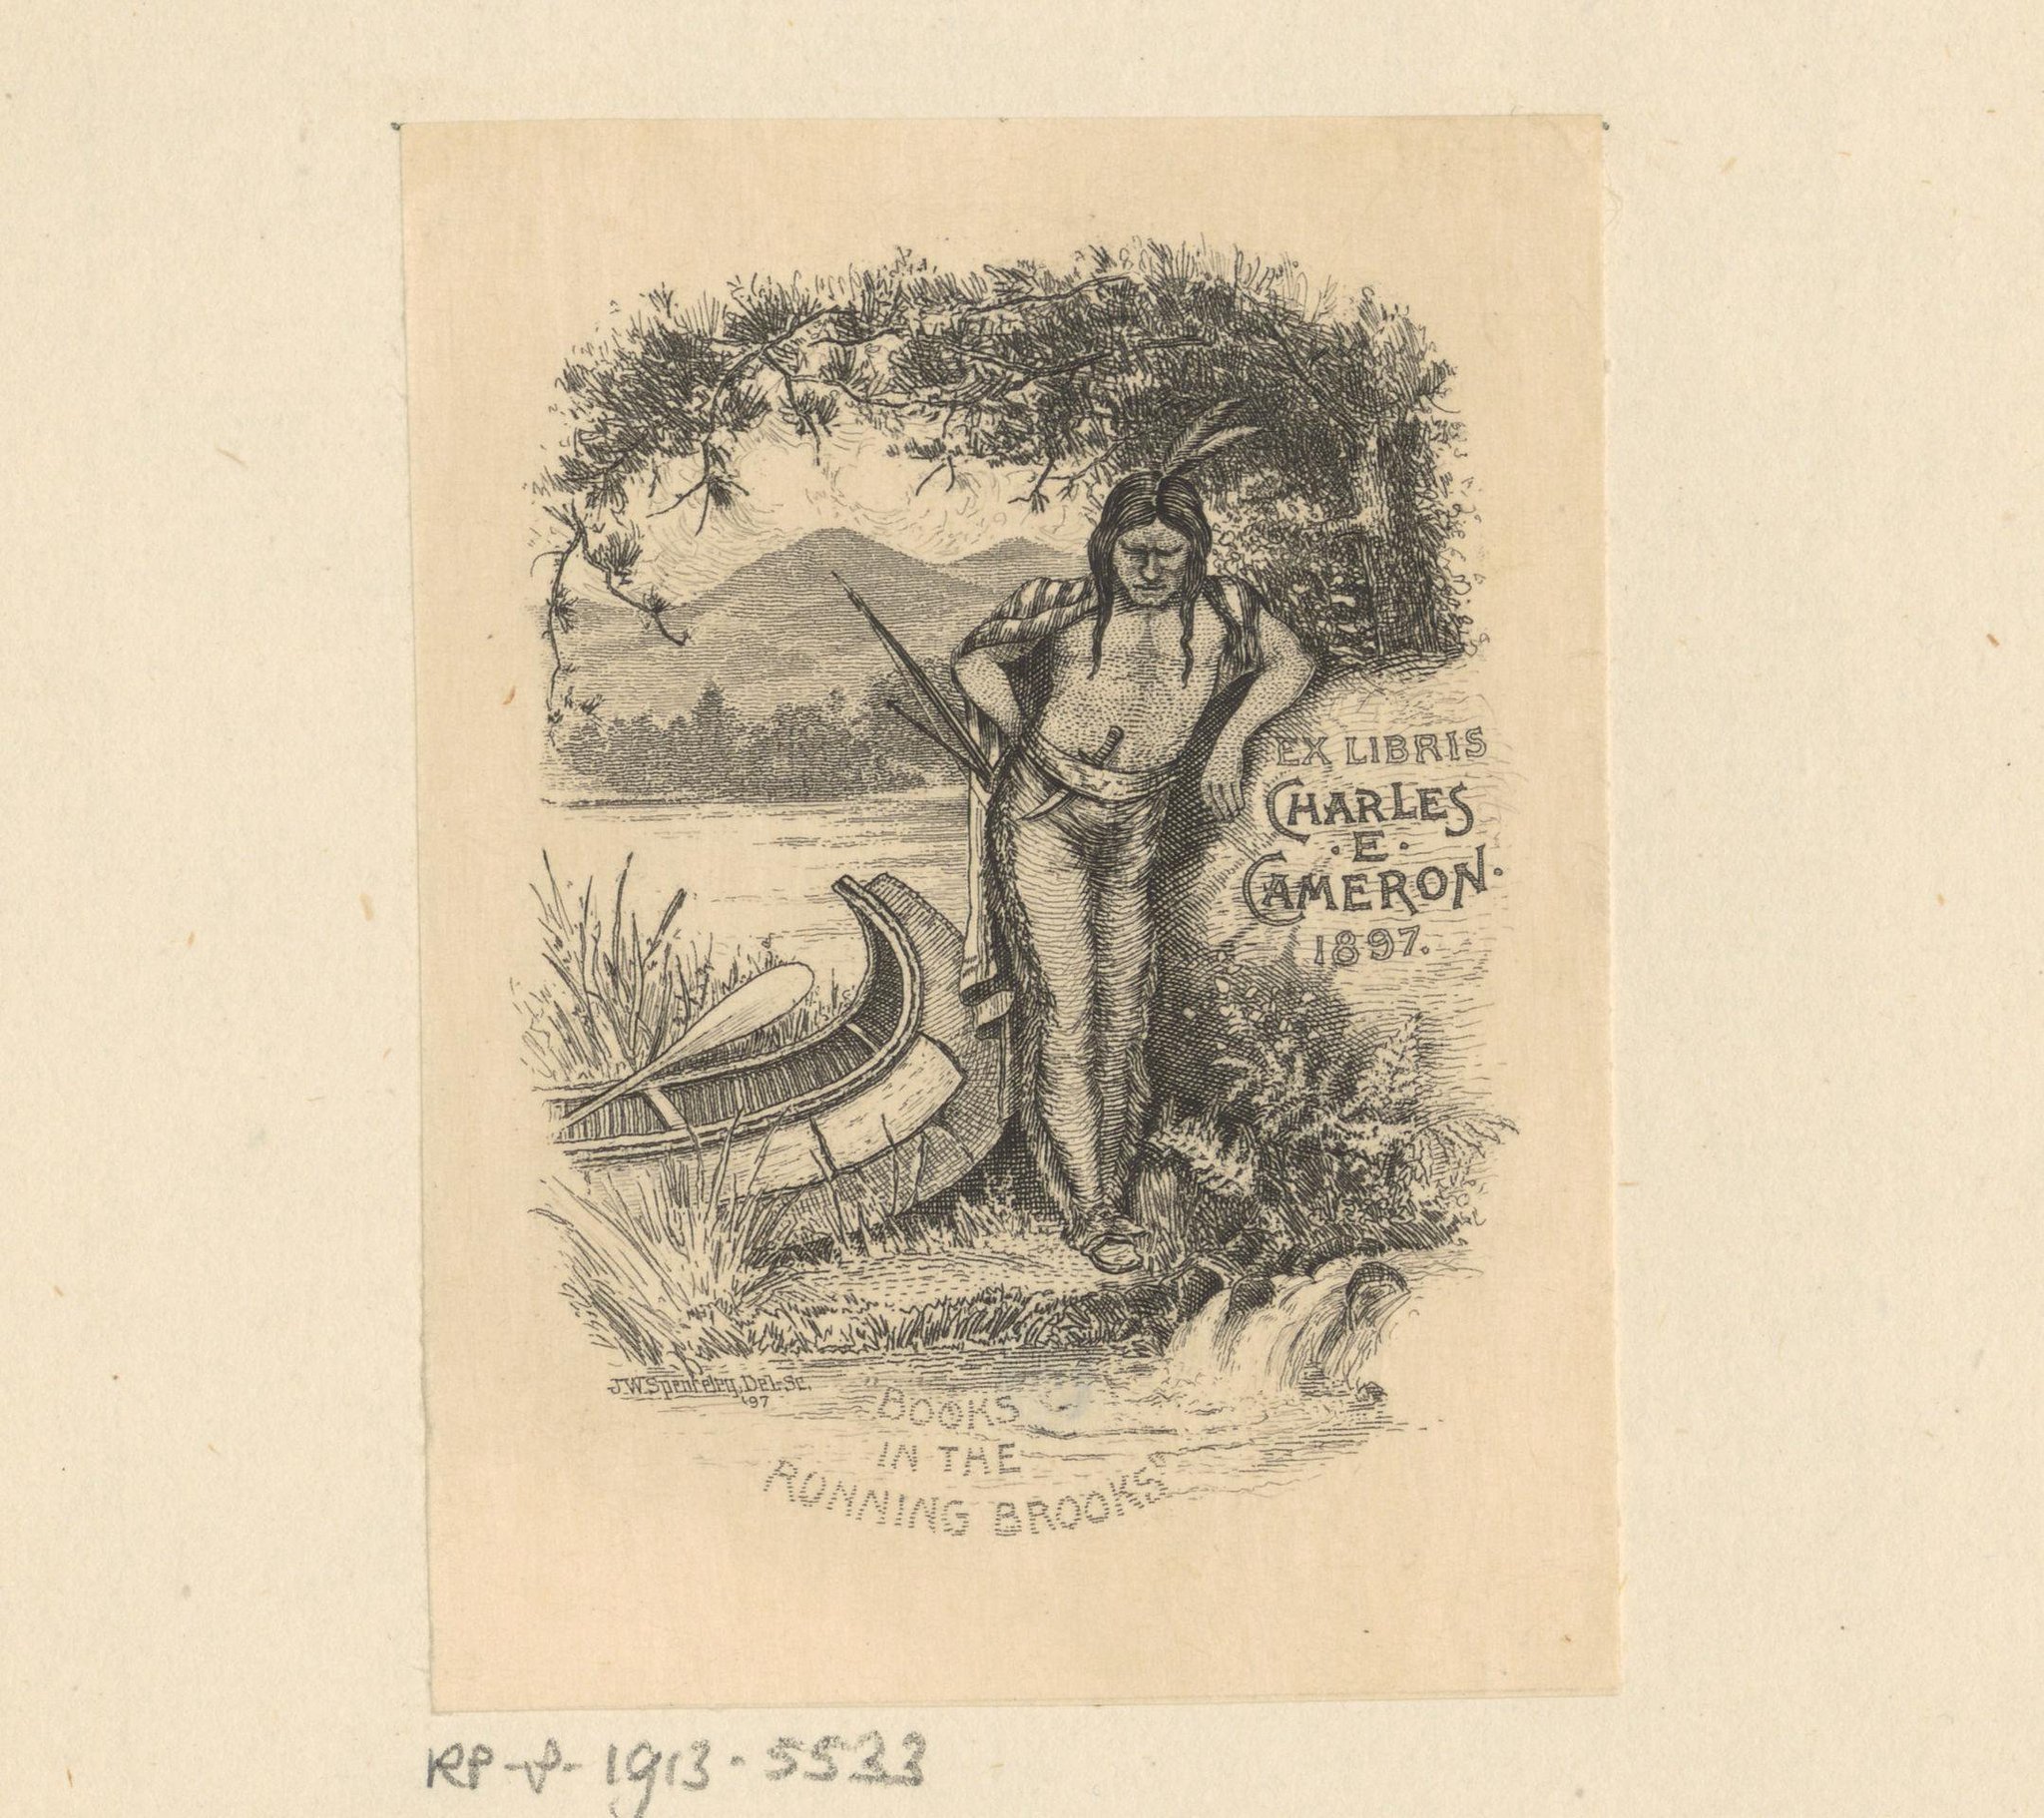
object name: bookplate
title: Ex libris van Charles E. Cameron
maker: joseph winfed spenceley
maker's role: print maker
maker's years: 1865-1908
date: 1897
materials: paper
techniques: etching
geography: north and central america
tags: canoeing, landscapes, indigenous peoples of north america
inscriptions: collector's mark: Lugt 2760, collector's mark: Lugt 2233